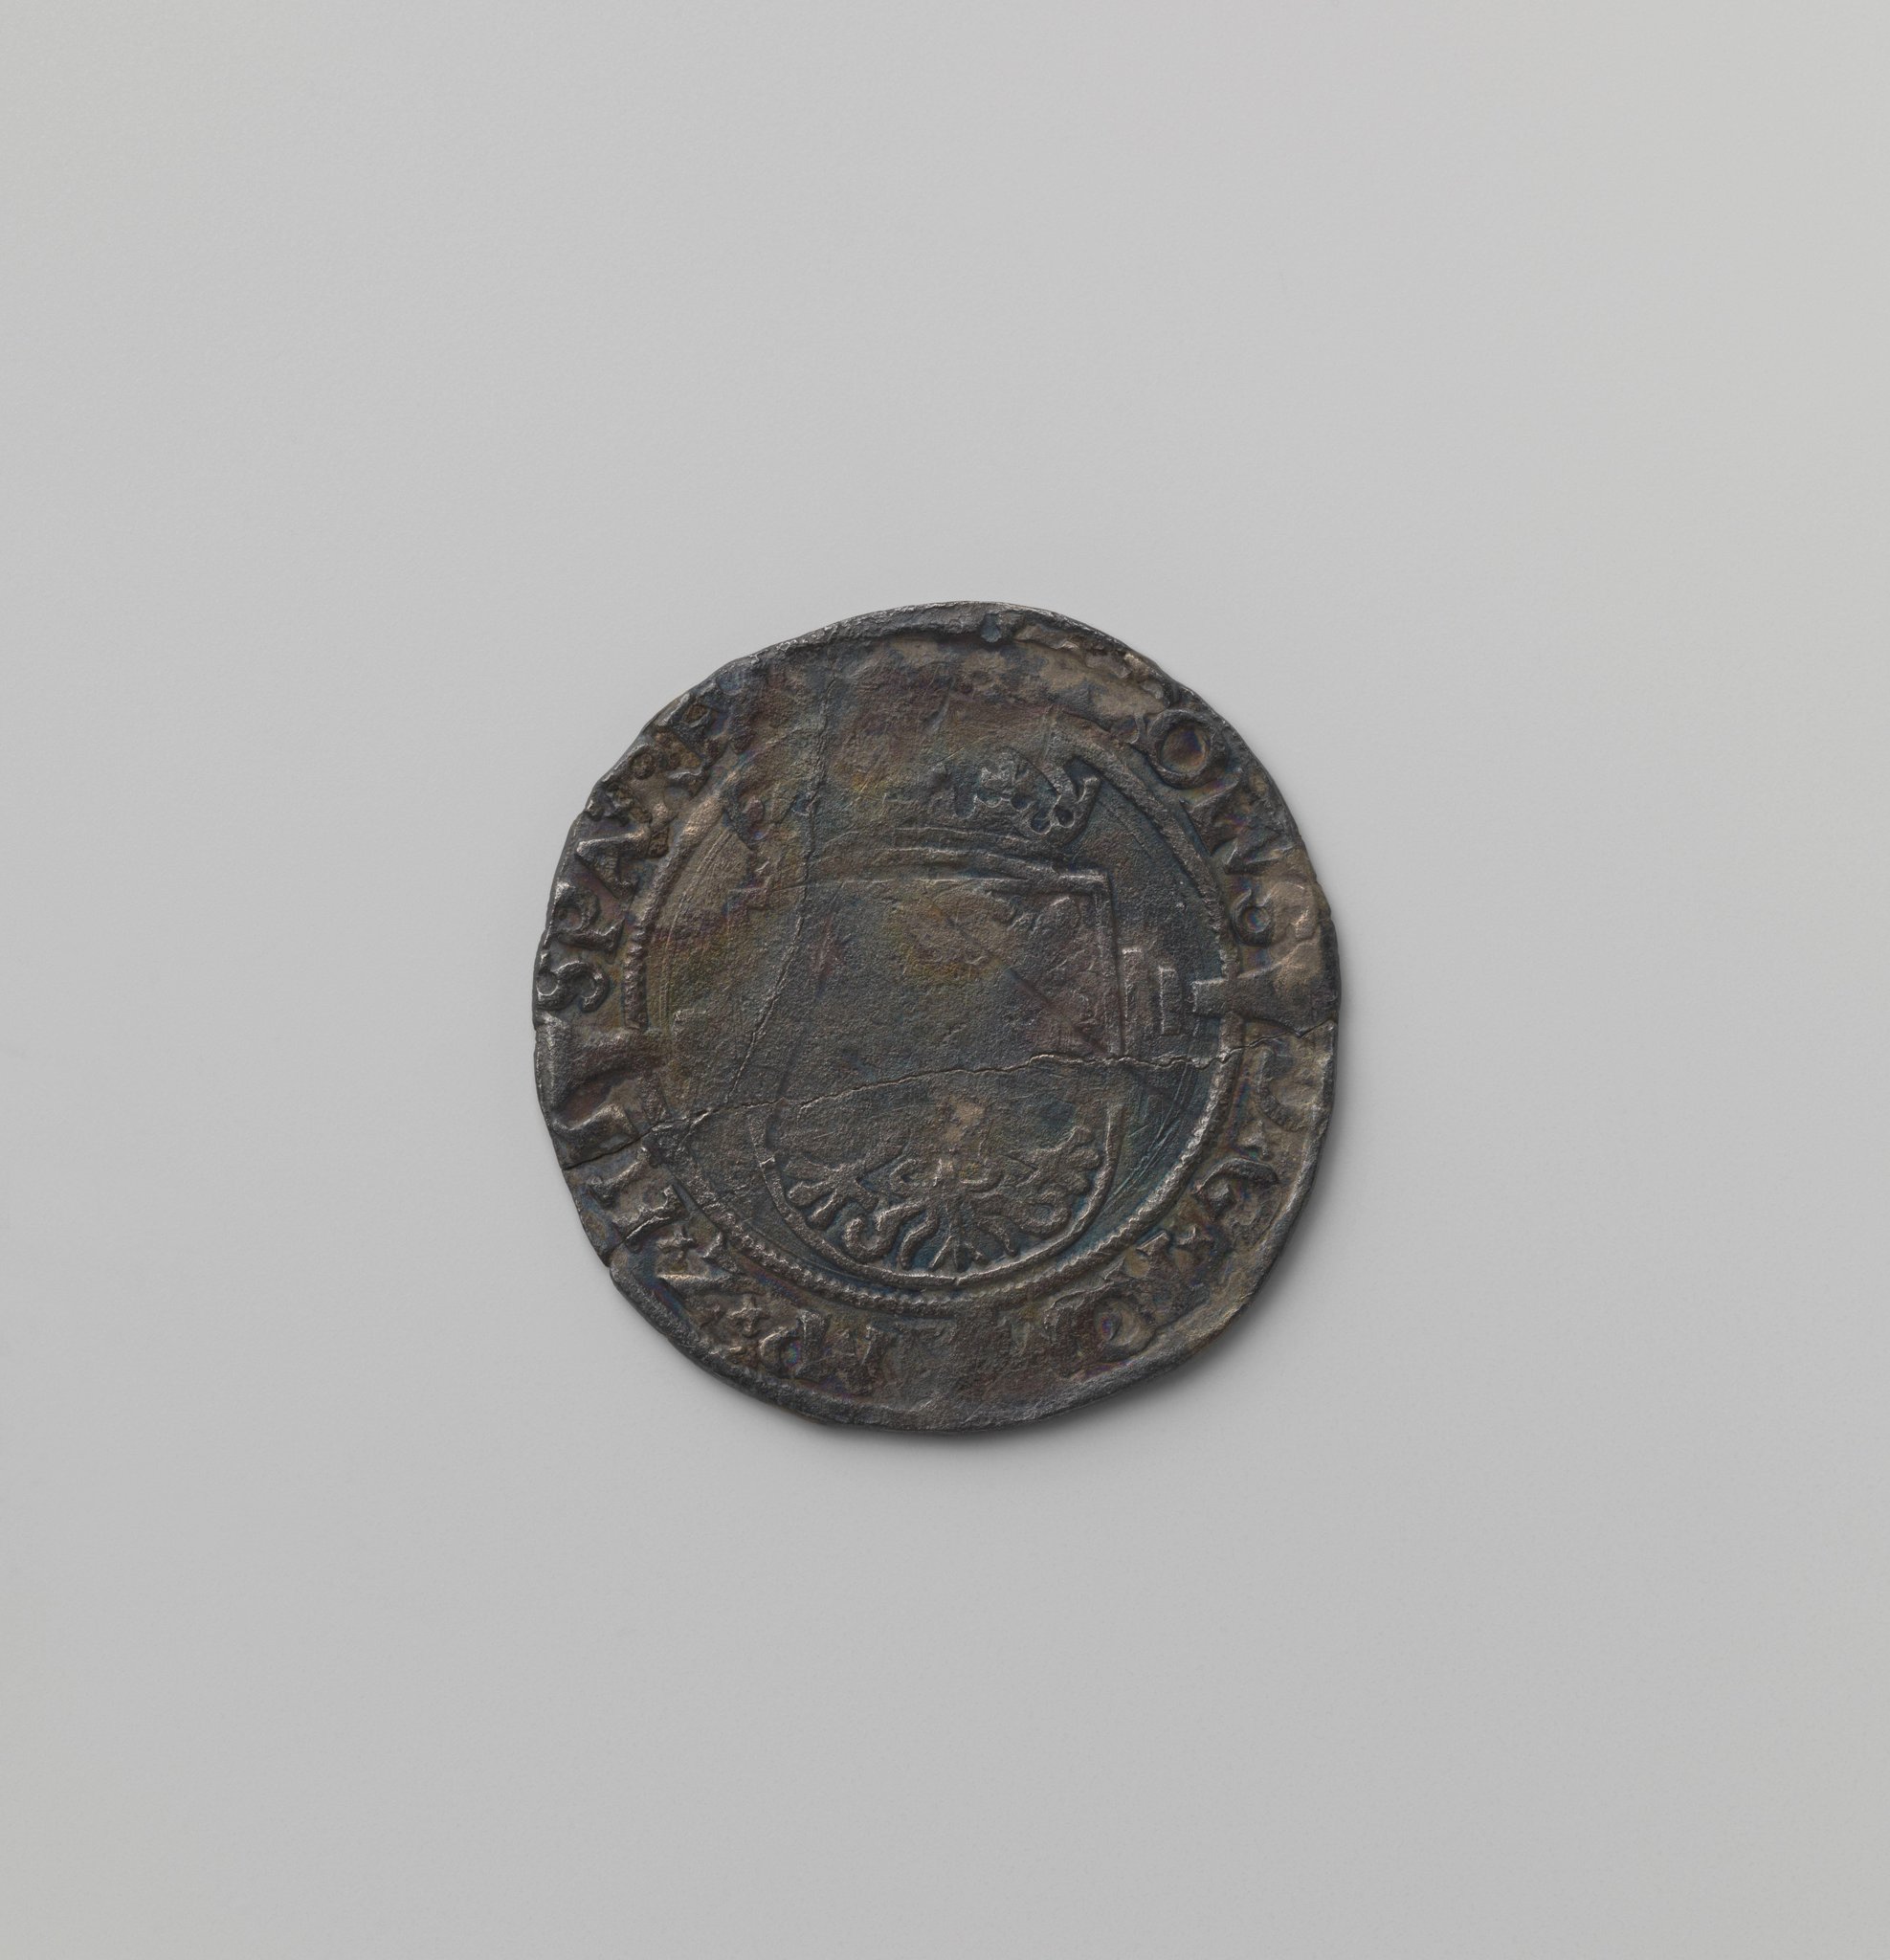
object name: halve reaal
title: Halve zilveren reaal uit Brabant van Karel V, 1515-1555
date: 1521-1555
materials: silver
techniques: striking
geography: antwerp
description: Zilveren munt. Voorzijde: gekroond wapenschild van het Duitse keizerrijk op een lang gevoet kruis. Keerzijde: gekroond samengesteld wapenschild.